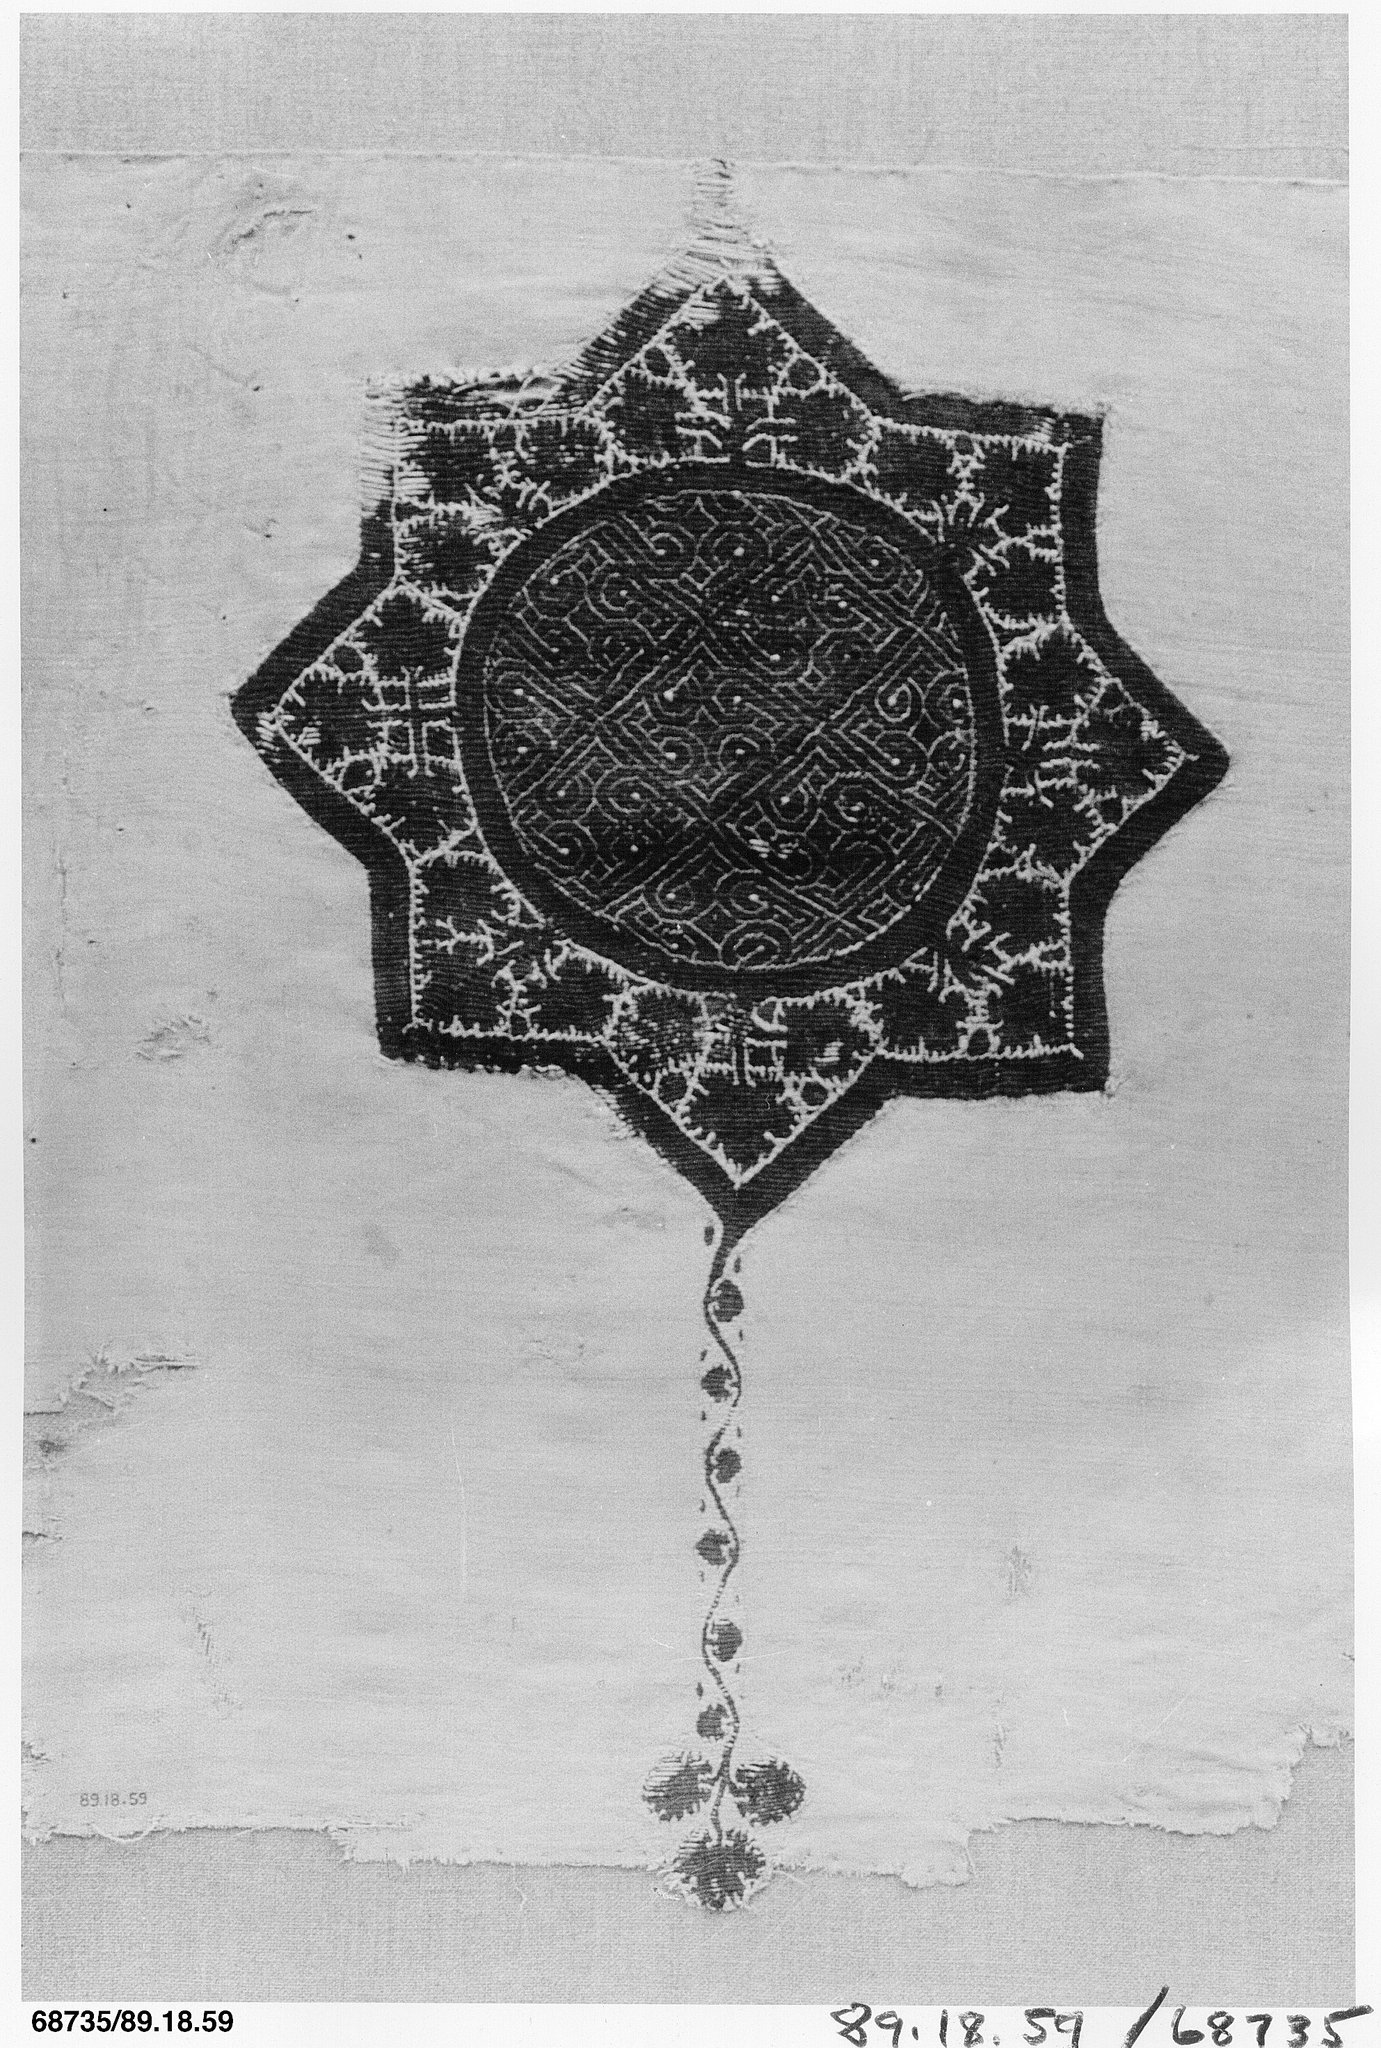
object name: textile fragment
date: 201-400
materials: linen, wool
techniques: weave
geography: egypt